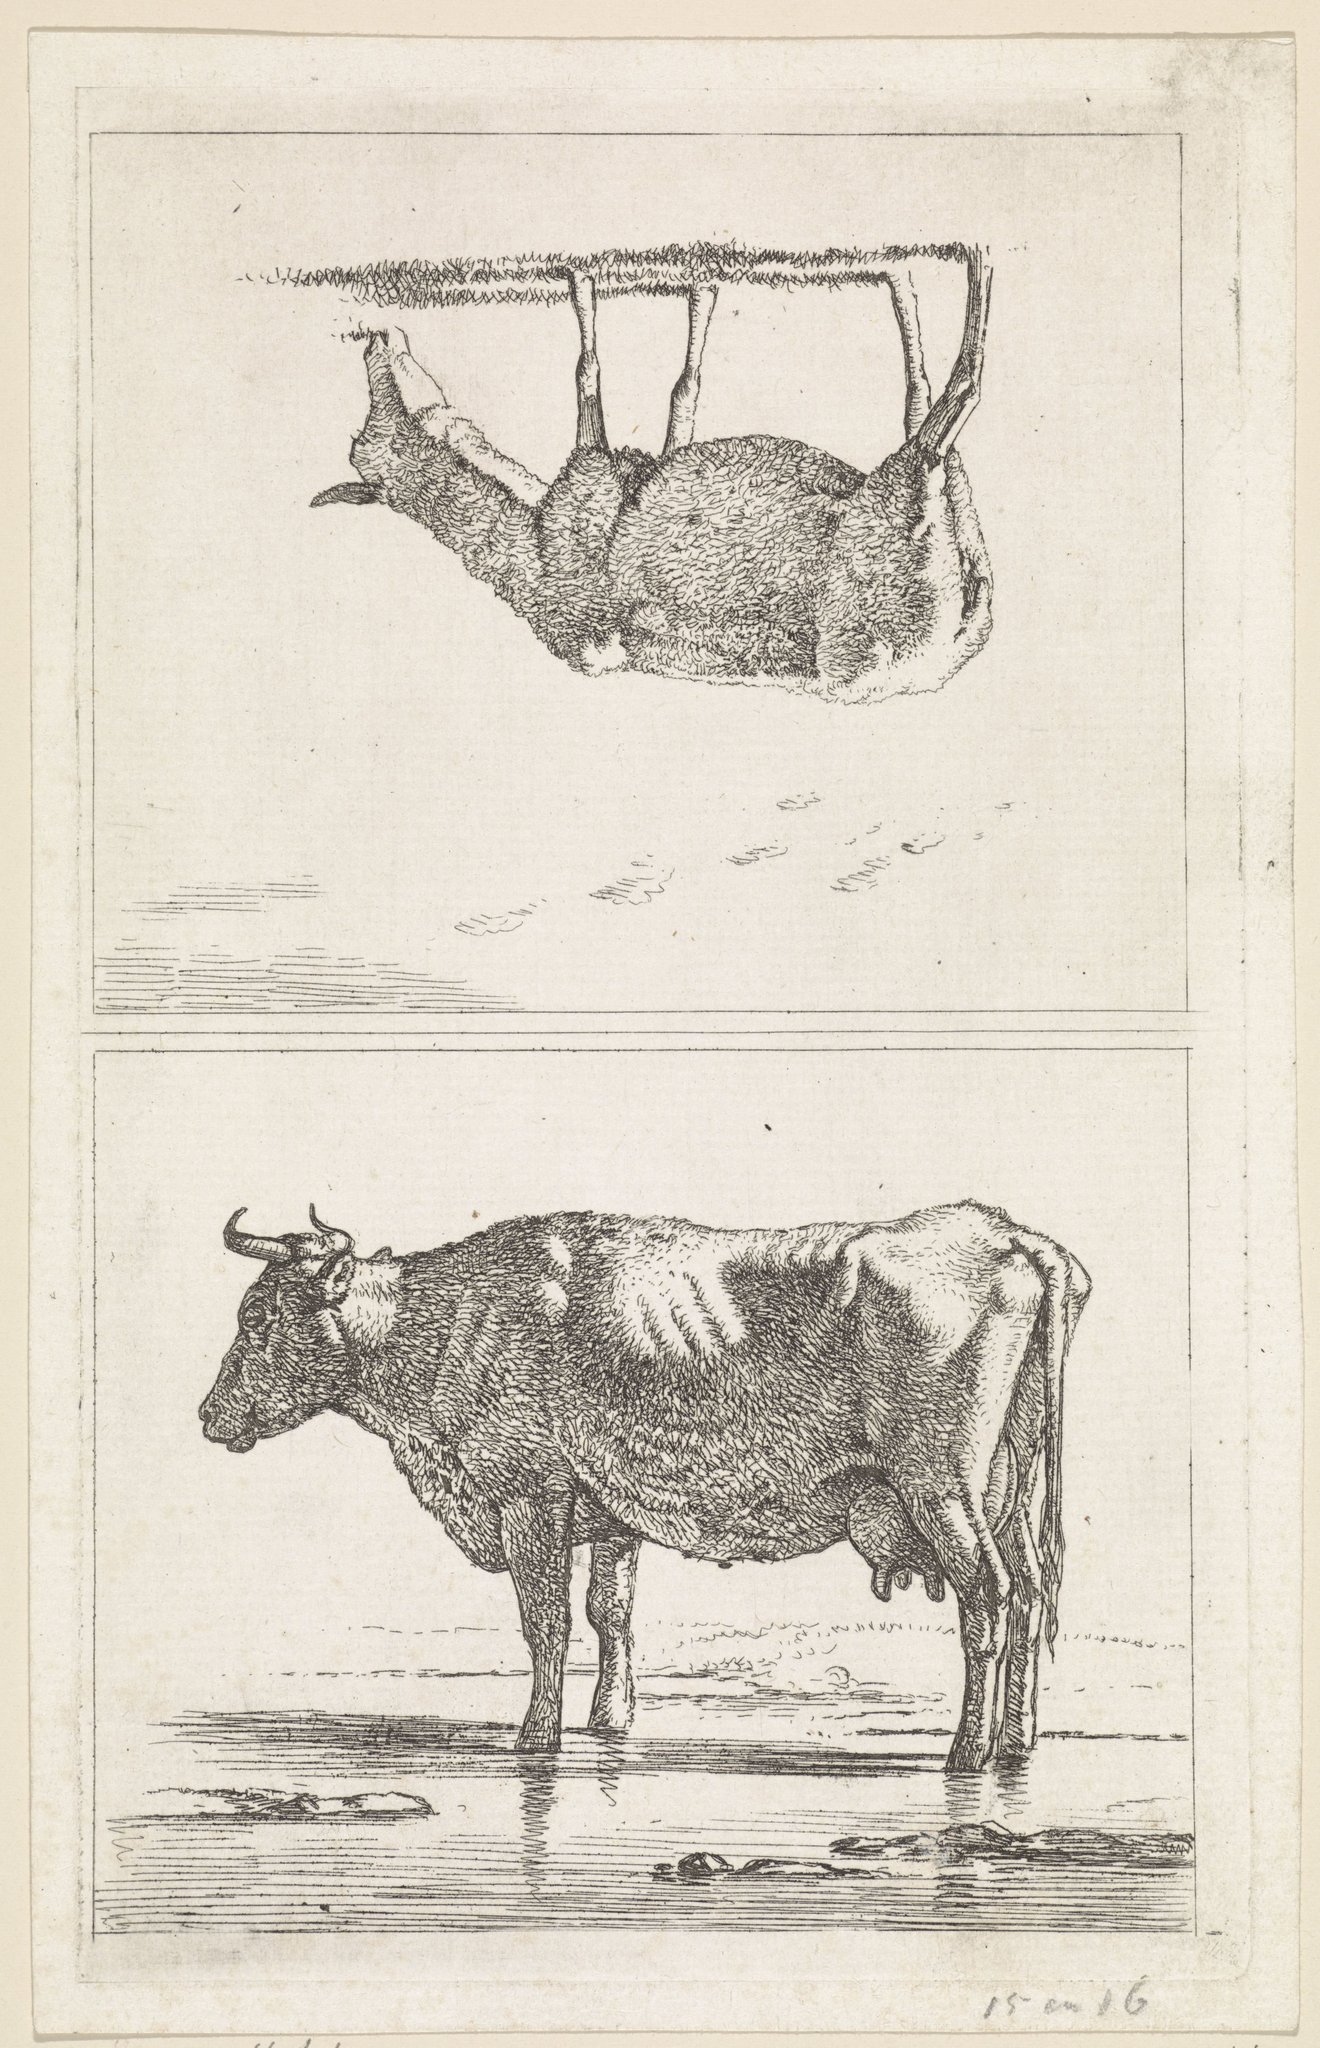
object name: print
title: Schaap naar rechts / Staande koe in het water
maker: wouter johannes van troostwijk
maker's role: draughtsman, painter, print maker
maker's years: 1782-1810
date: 1792-1810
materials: paper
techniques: etching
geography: amsterdam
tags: cow, sheep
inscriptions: collector's mark: Lugt 2165